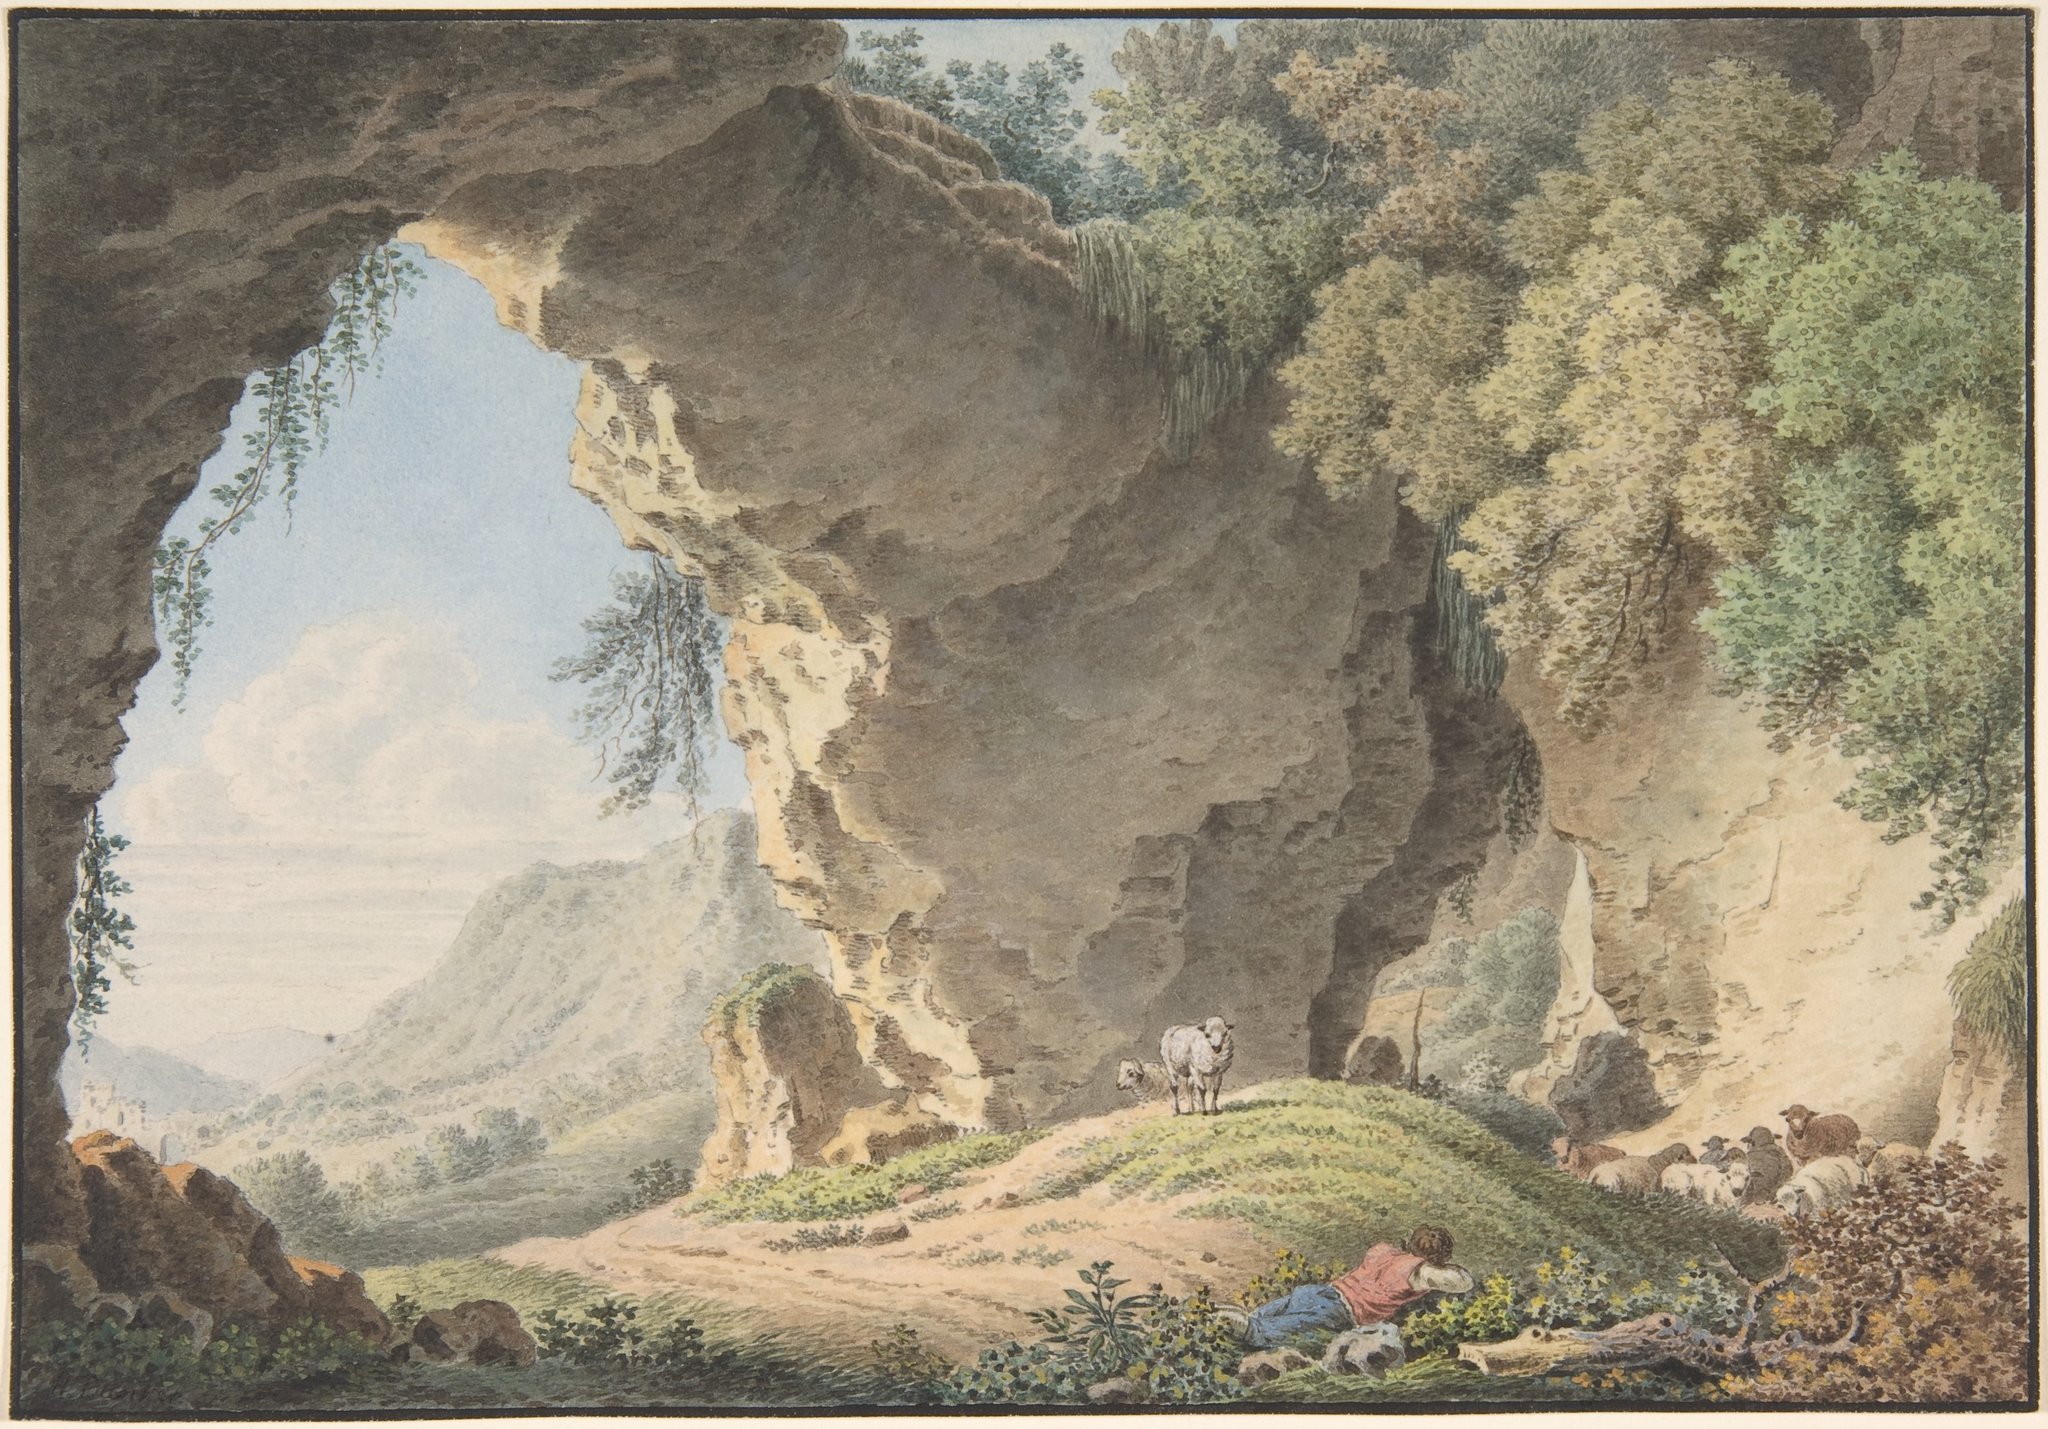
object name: drawing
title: Rocky Landscape with Sleeping Shepherd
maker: philip heinrich dunker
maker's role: artist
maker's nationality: german, born switzerland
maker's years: 1780-1836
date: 1817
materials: ink, watercolor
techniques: pen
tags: sleeping,sheep,landscapes,shepherds